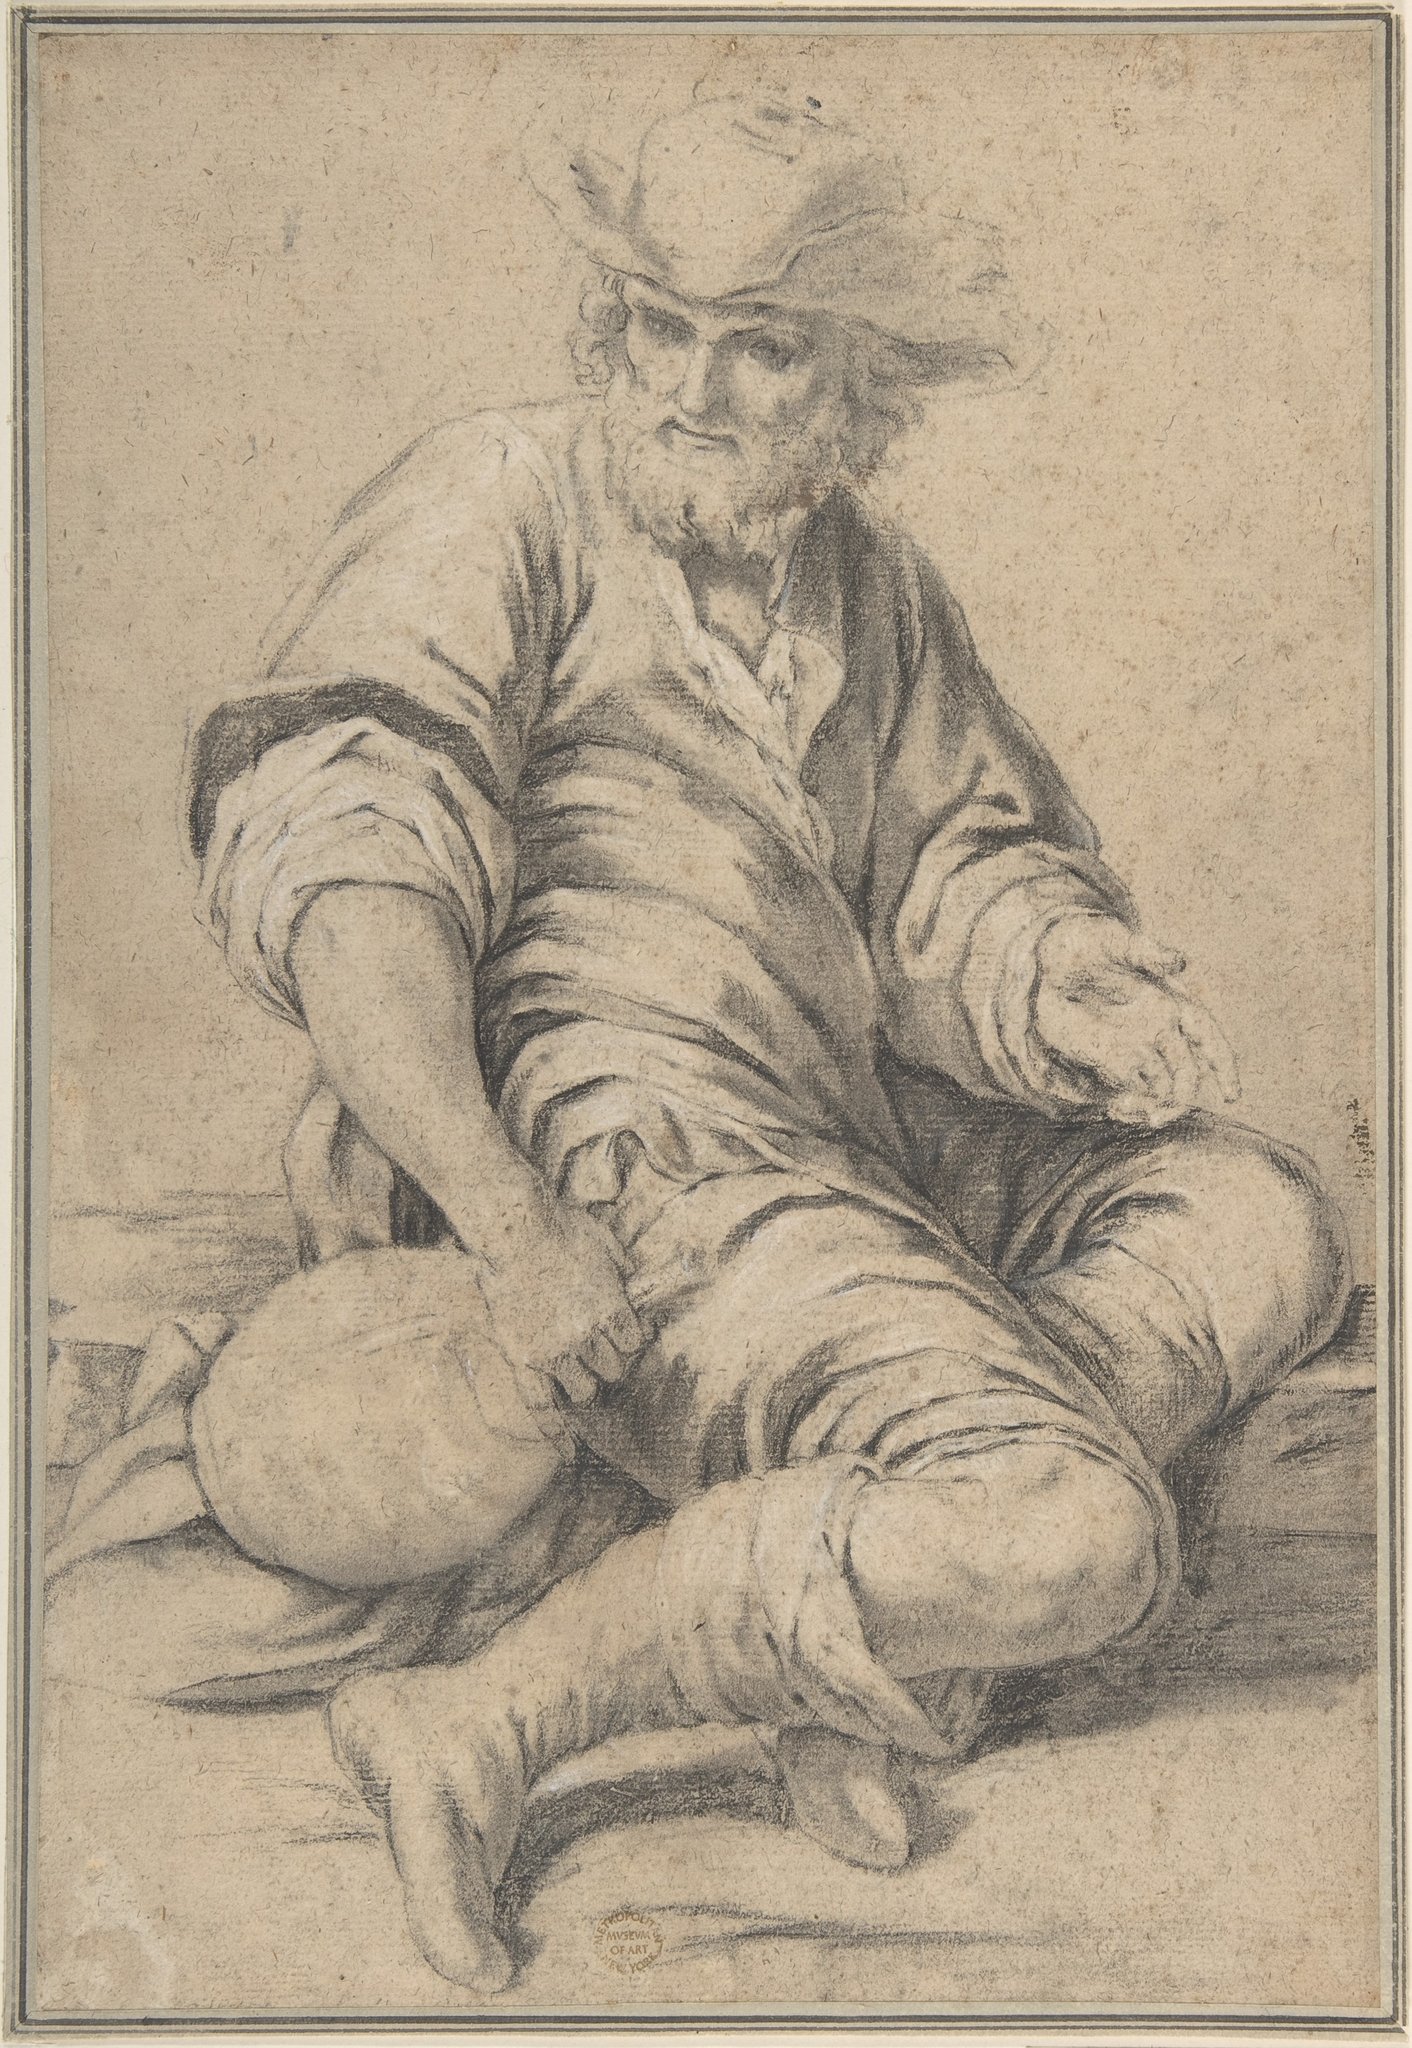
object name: drawing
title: Seated Man Holding a Jug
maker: anonymous, italian, roman-bolognese, 17th century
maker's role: artist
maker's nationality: italian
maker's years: 1600-1700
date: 1601-1700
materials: chalk, paper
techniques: highlighting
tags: men,jugs